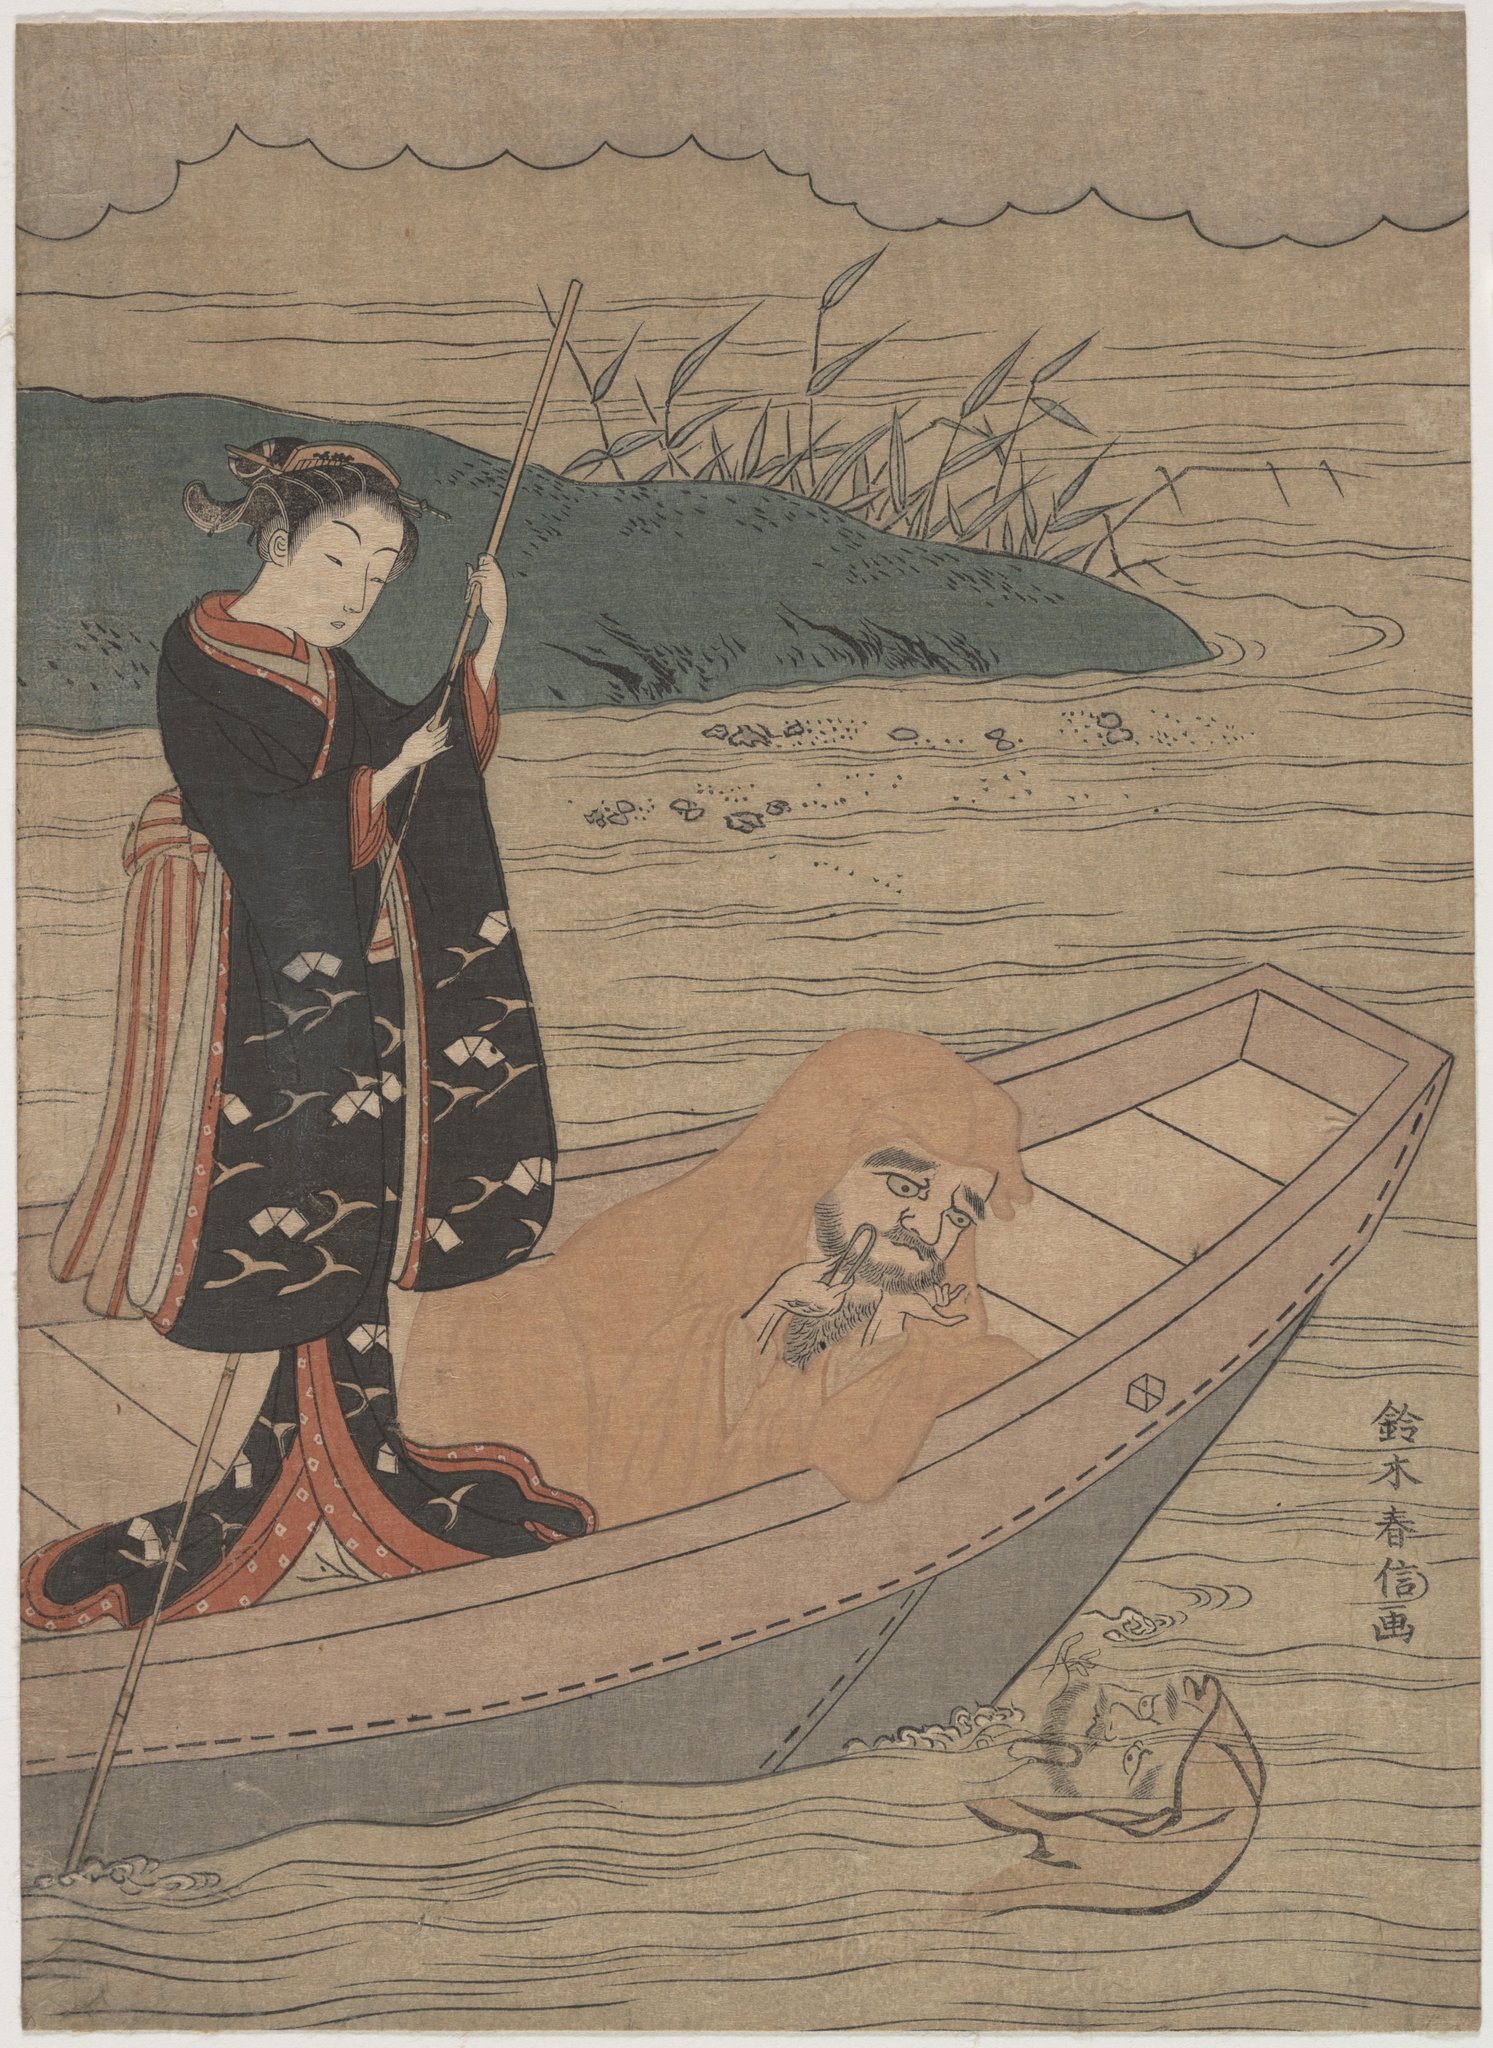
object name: print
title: Daruma in a Boat with an Attendant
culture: japanese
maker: suzuki harunobu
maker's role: artist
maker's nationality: japanese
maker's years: 1725-1770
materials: ink, paper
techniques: nishiki e, woodblock print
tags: men,women,boats